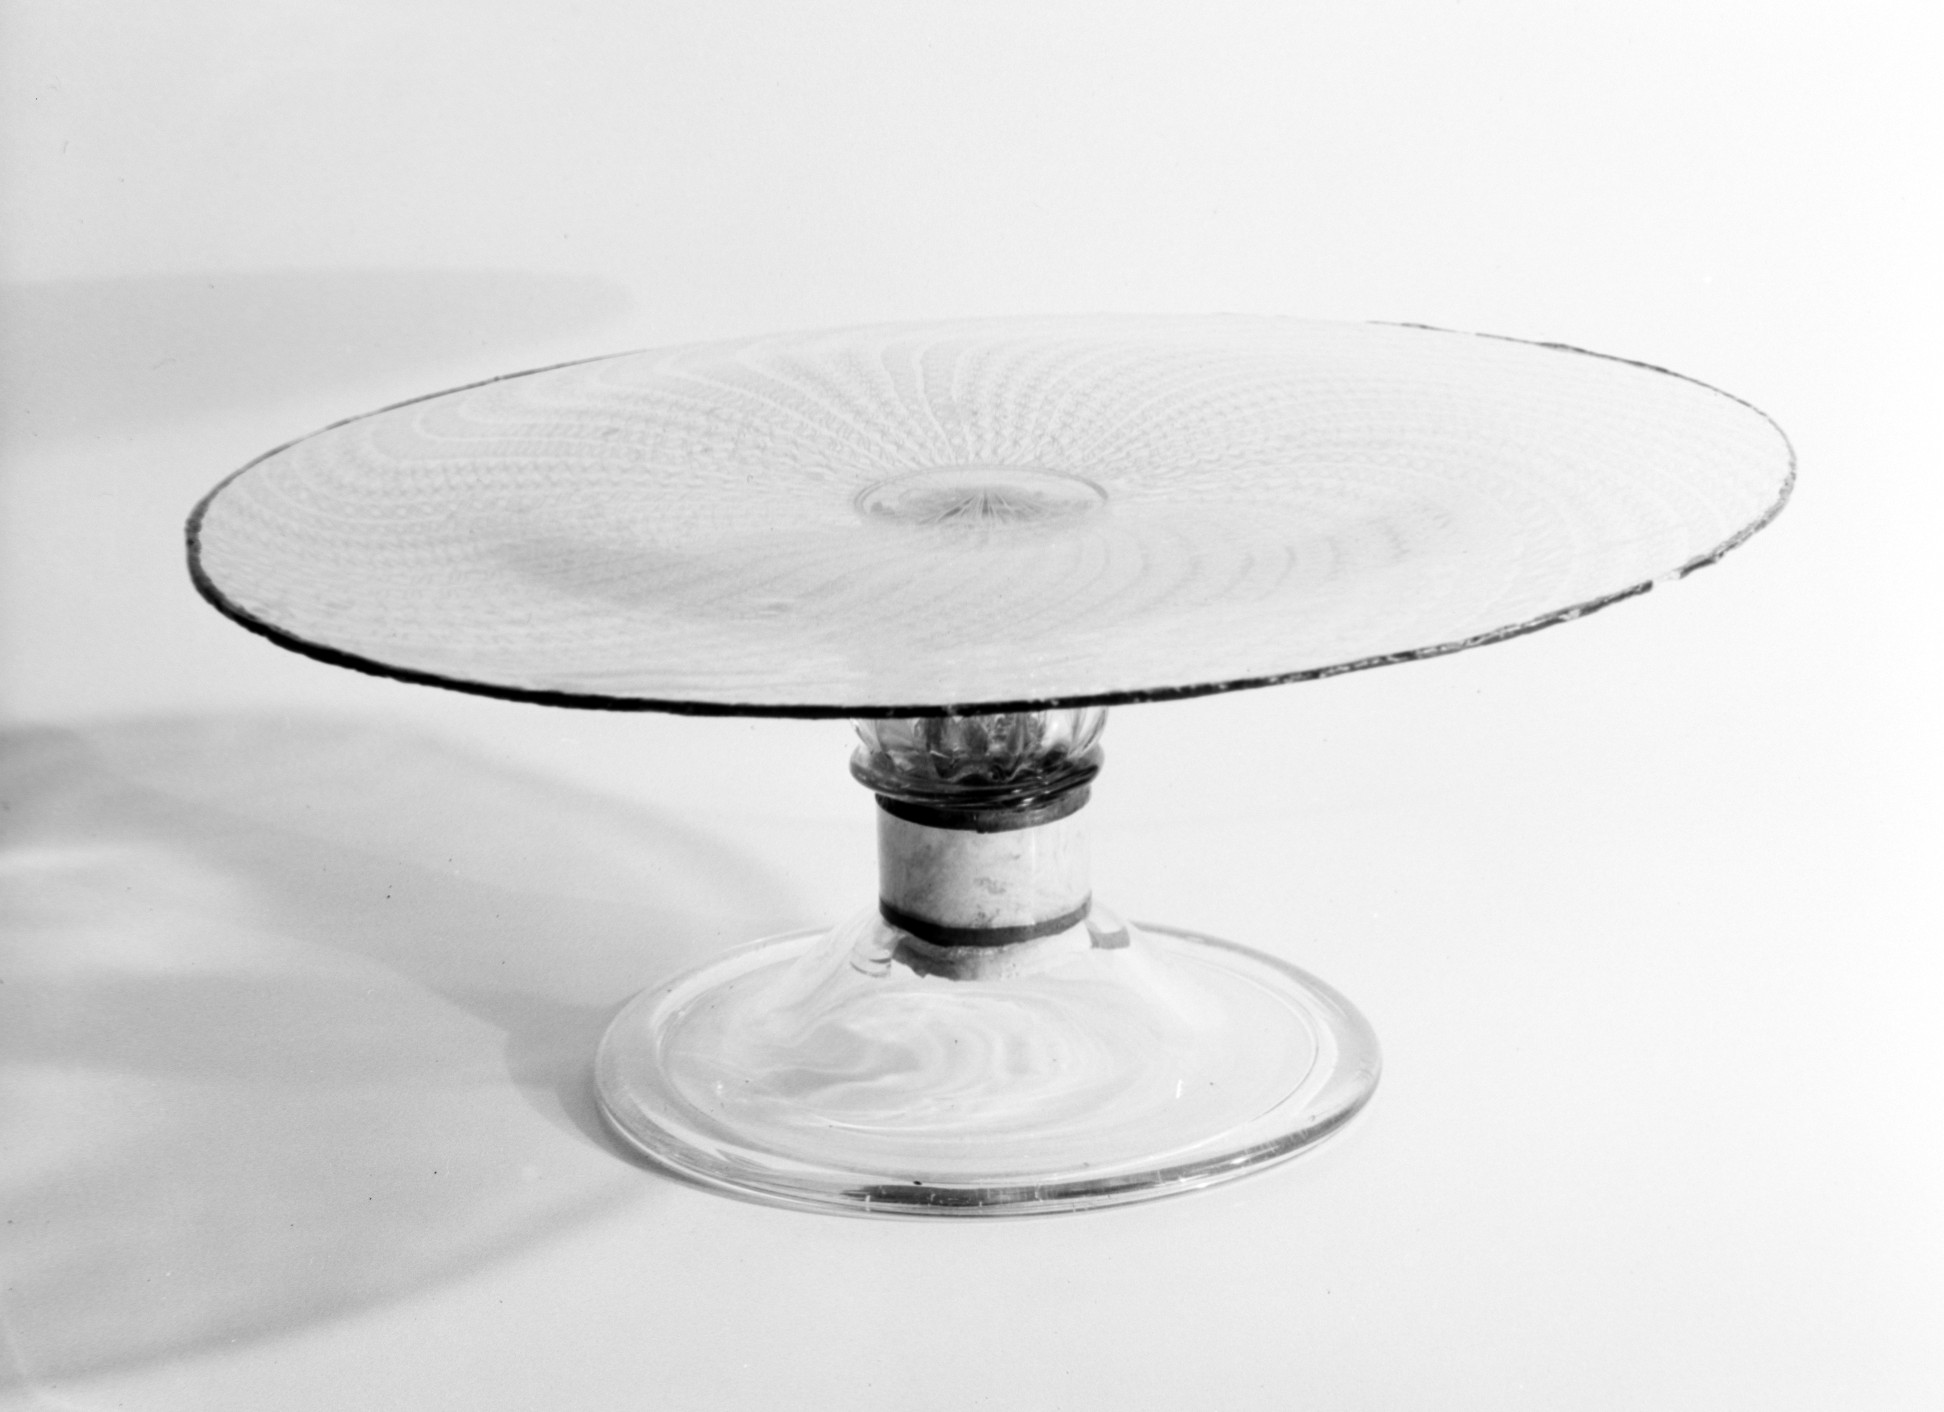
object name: tazza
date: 1701-1800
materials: glass